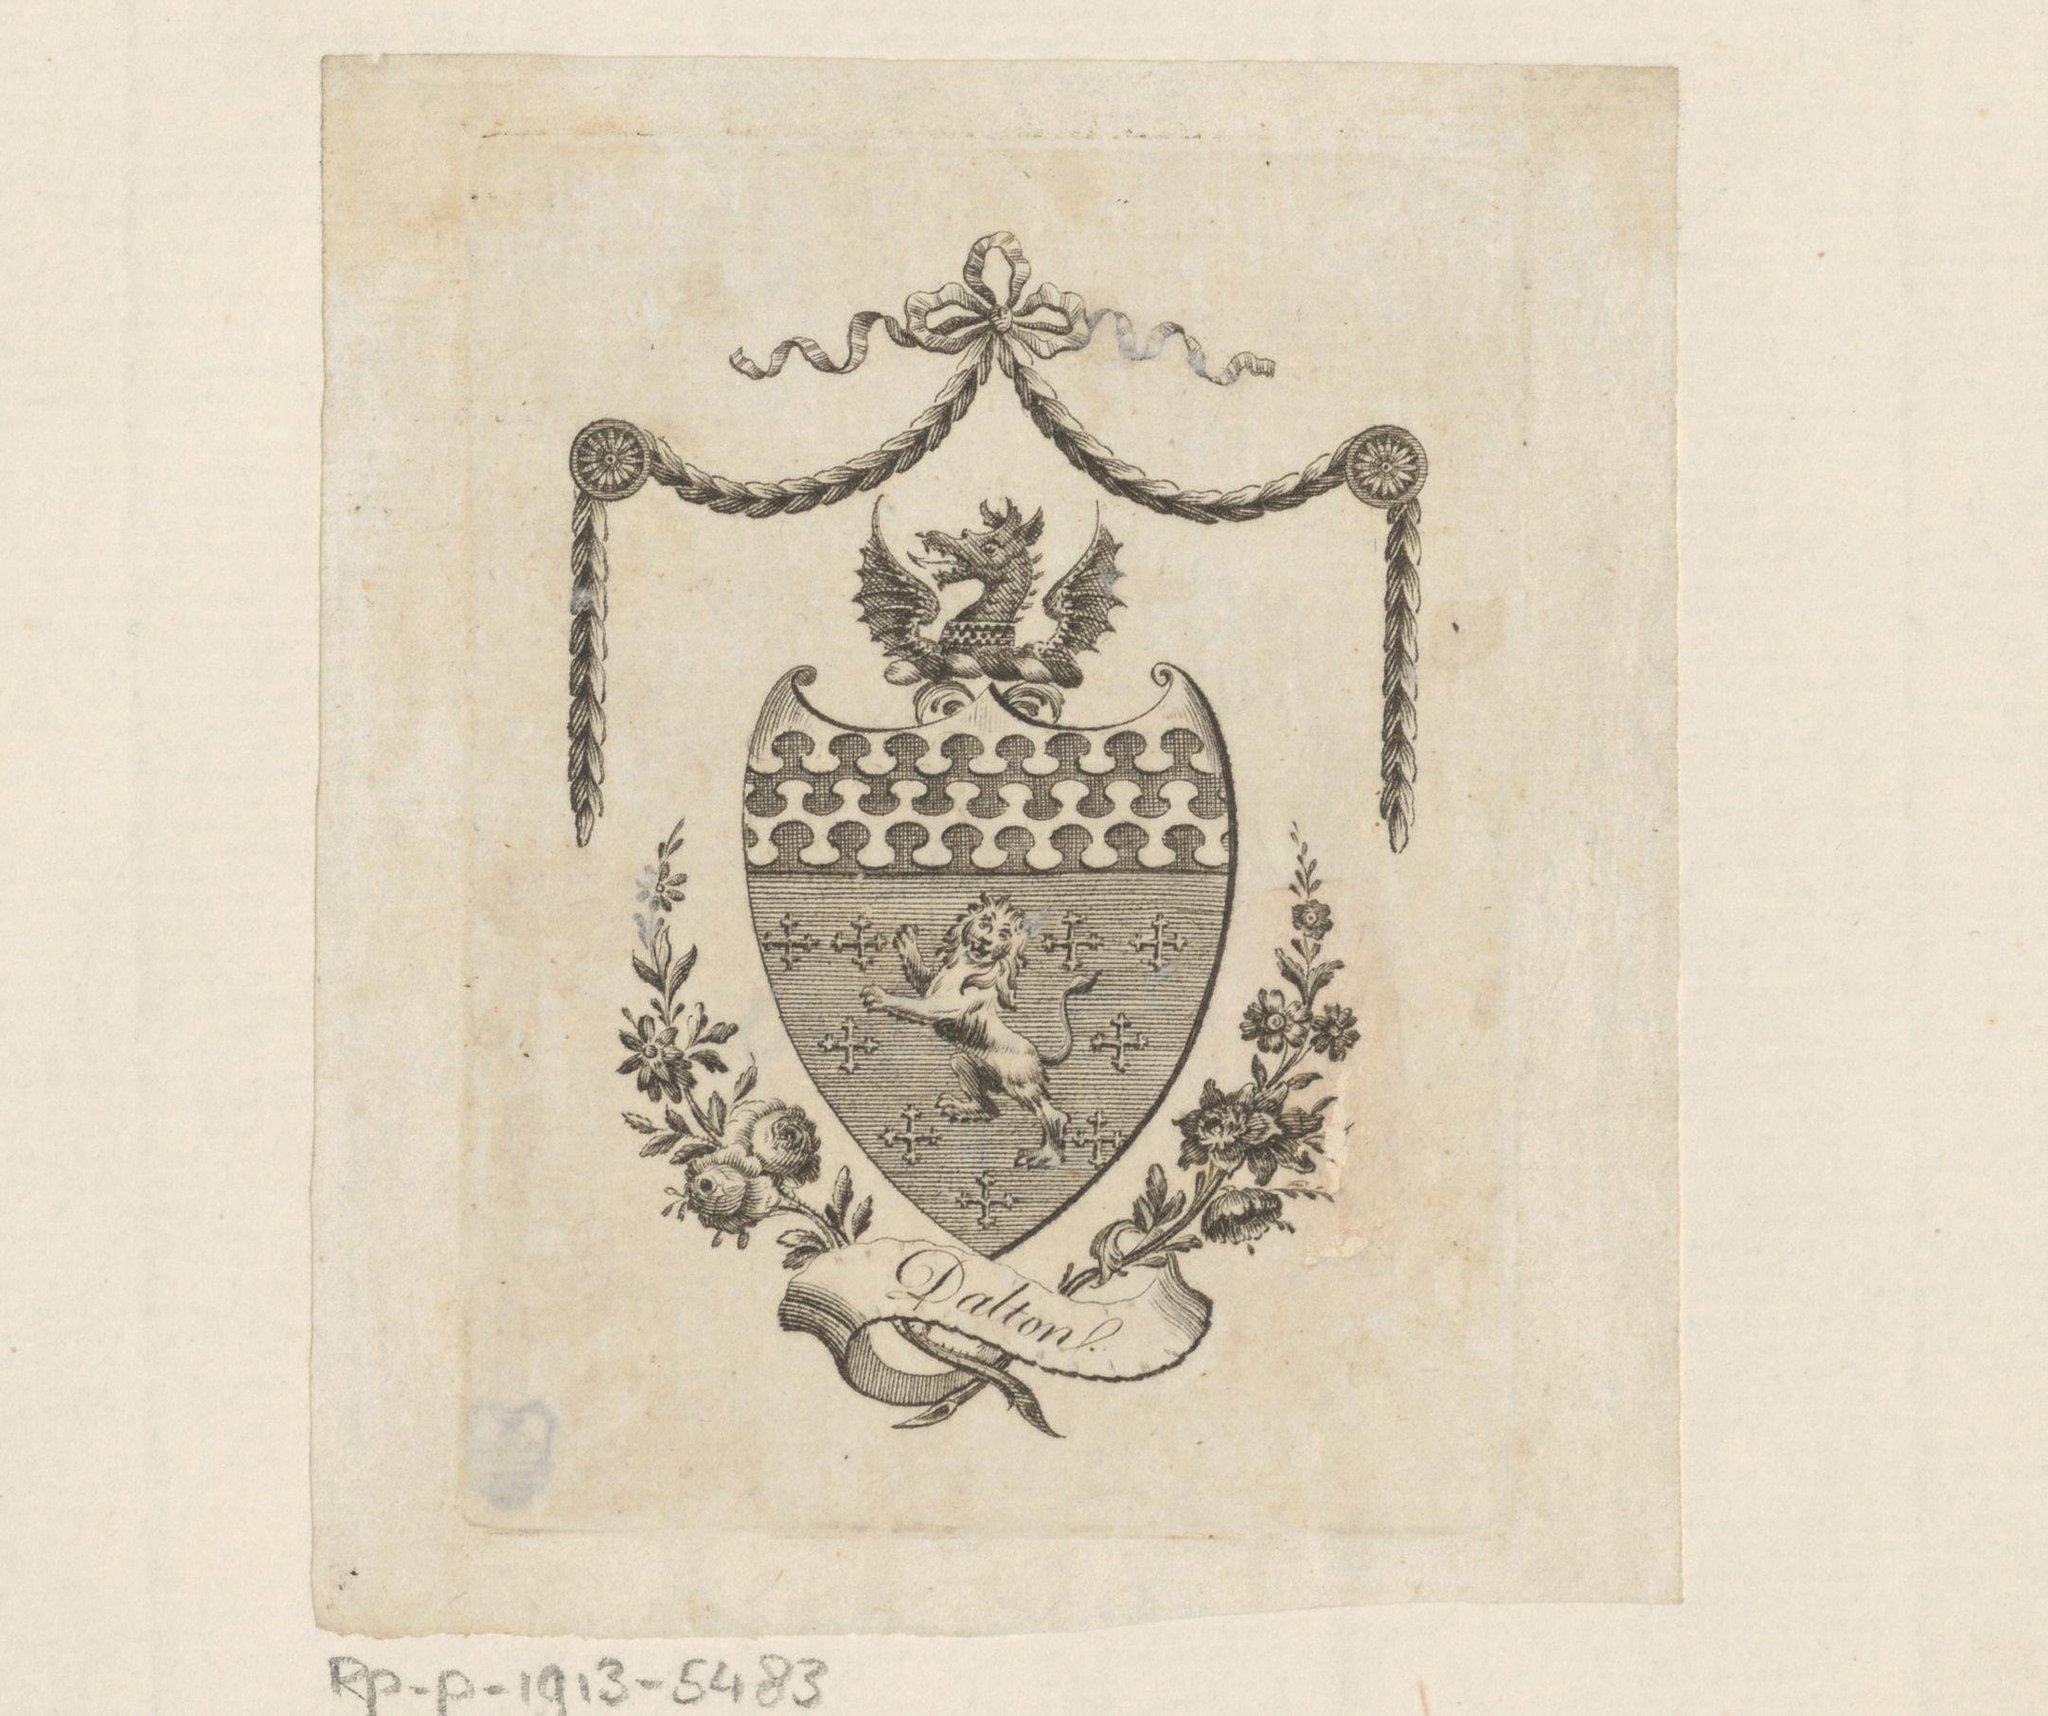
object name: bookplate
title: Ex libris van Dalton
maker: Anonymous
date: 1700-1799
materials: paper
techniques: engraving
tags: armorial bearing, heraldry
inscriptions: collector's mark: Lugt 2760, collector's mark: Lugt 2233